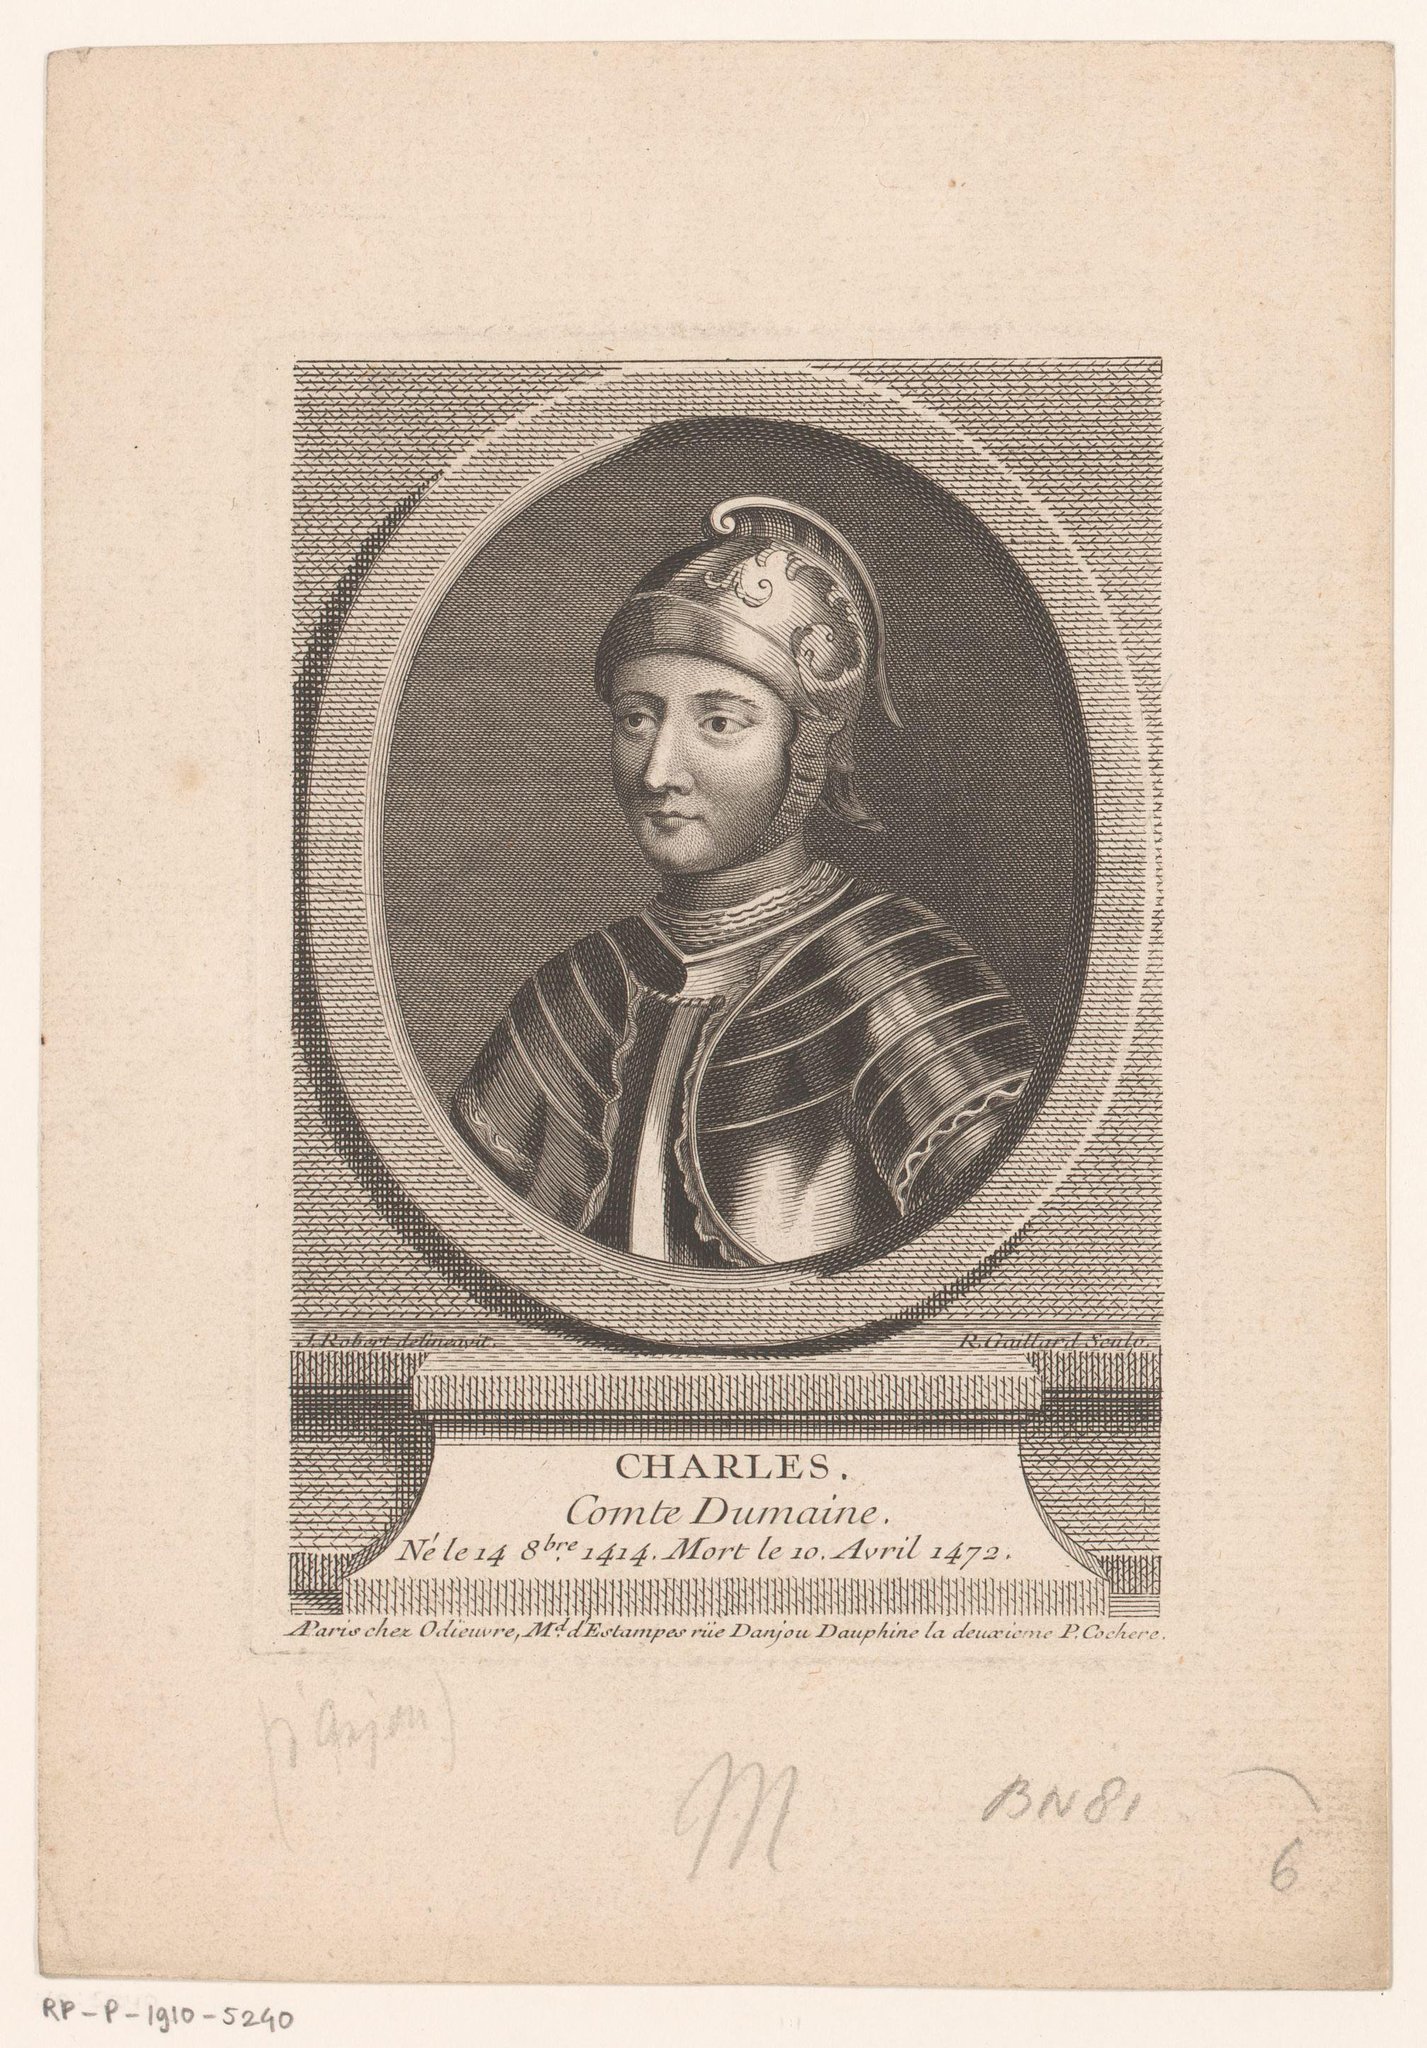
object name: book illustration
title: Portret van Karel IV van Maine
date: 1755-1765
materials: paper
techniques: engraving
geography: paris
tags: historical persons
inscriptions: collector's mark: Lugt 2228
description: Mogelijk prent uit: Dreux du Radier, Jean-François. L'Europe illustré, contenant l'histoire abregée des souverains, des princes, des prélats, des ministres, (...) en Europe: dans le XVe. siècle compris, jusqu'à présent. Parijs: Michel Odieuvre en André-François Le Breton, 1755-1765, dl. 2.